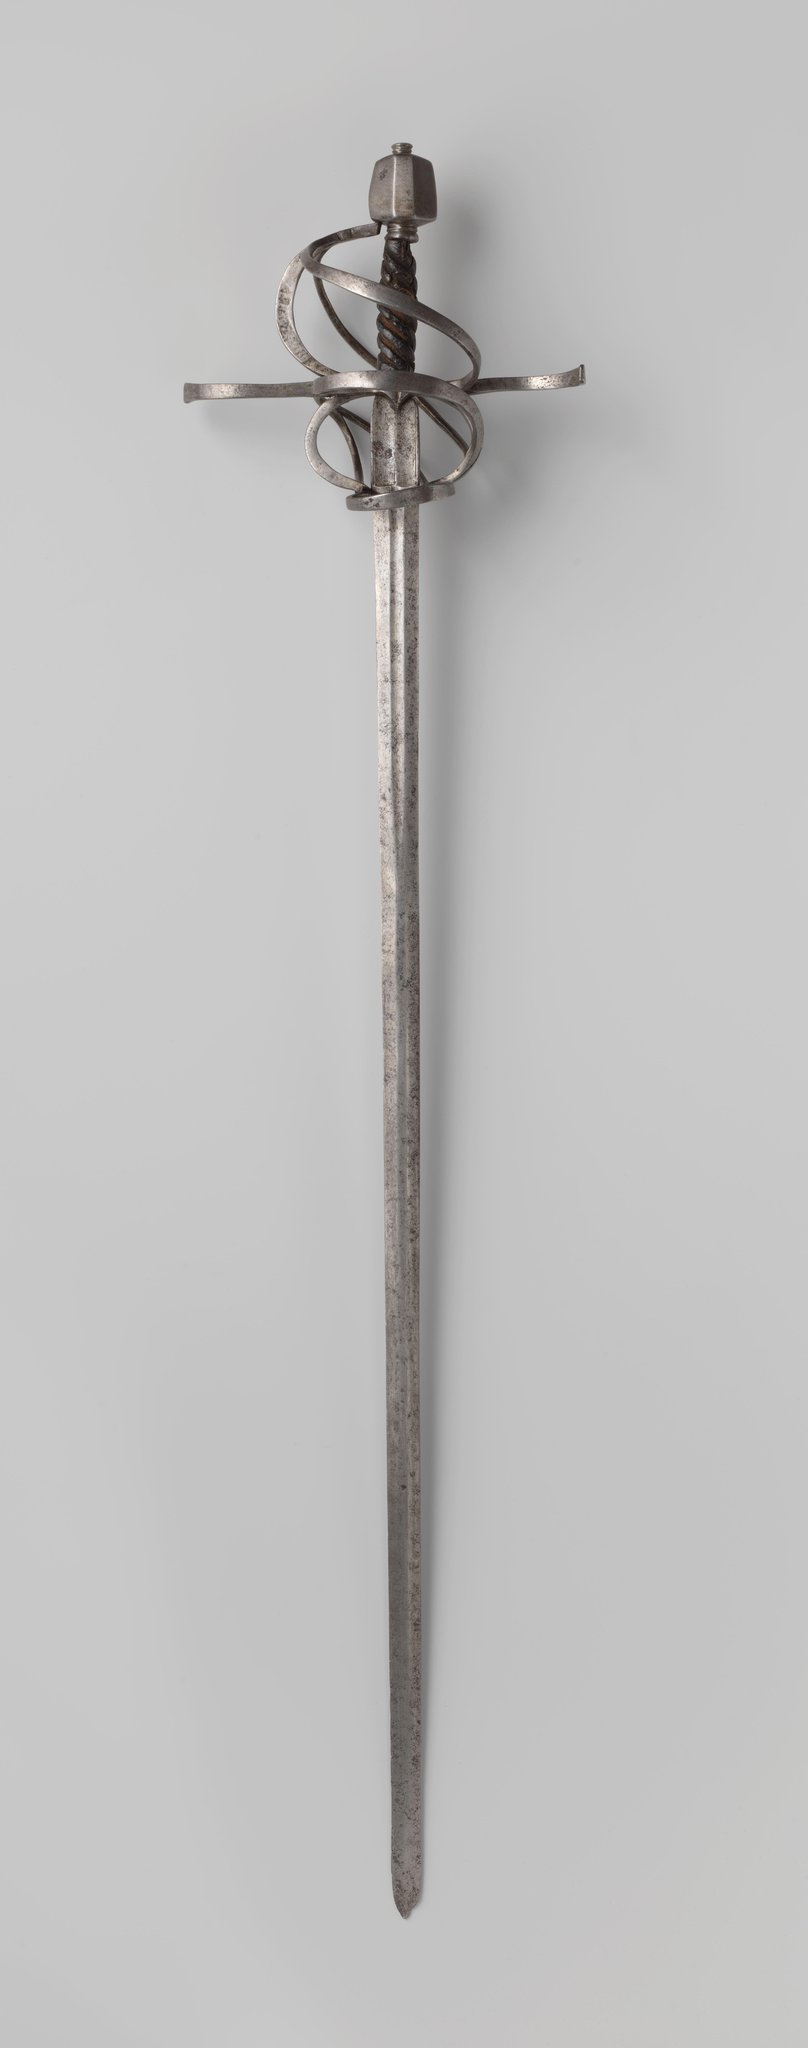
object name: sword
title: Degen of rapier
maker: Anonymous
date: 1550-1650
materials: iron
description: Degen. De brede kling aan de zijden afgeplat. Gevest met getordeerde greep, vroeger omwoeld, s-vormige pareerstang, driedubbele pareerbeugel, duimring en naar beneden gebogen schutbeugel (pas d'ane). Einde 16de of begin 17de eeuw. Lengte van de kling 0,87 m.